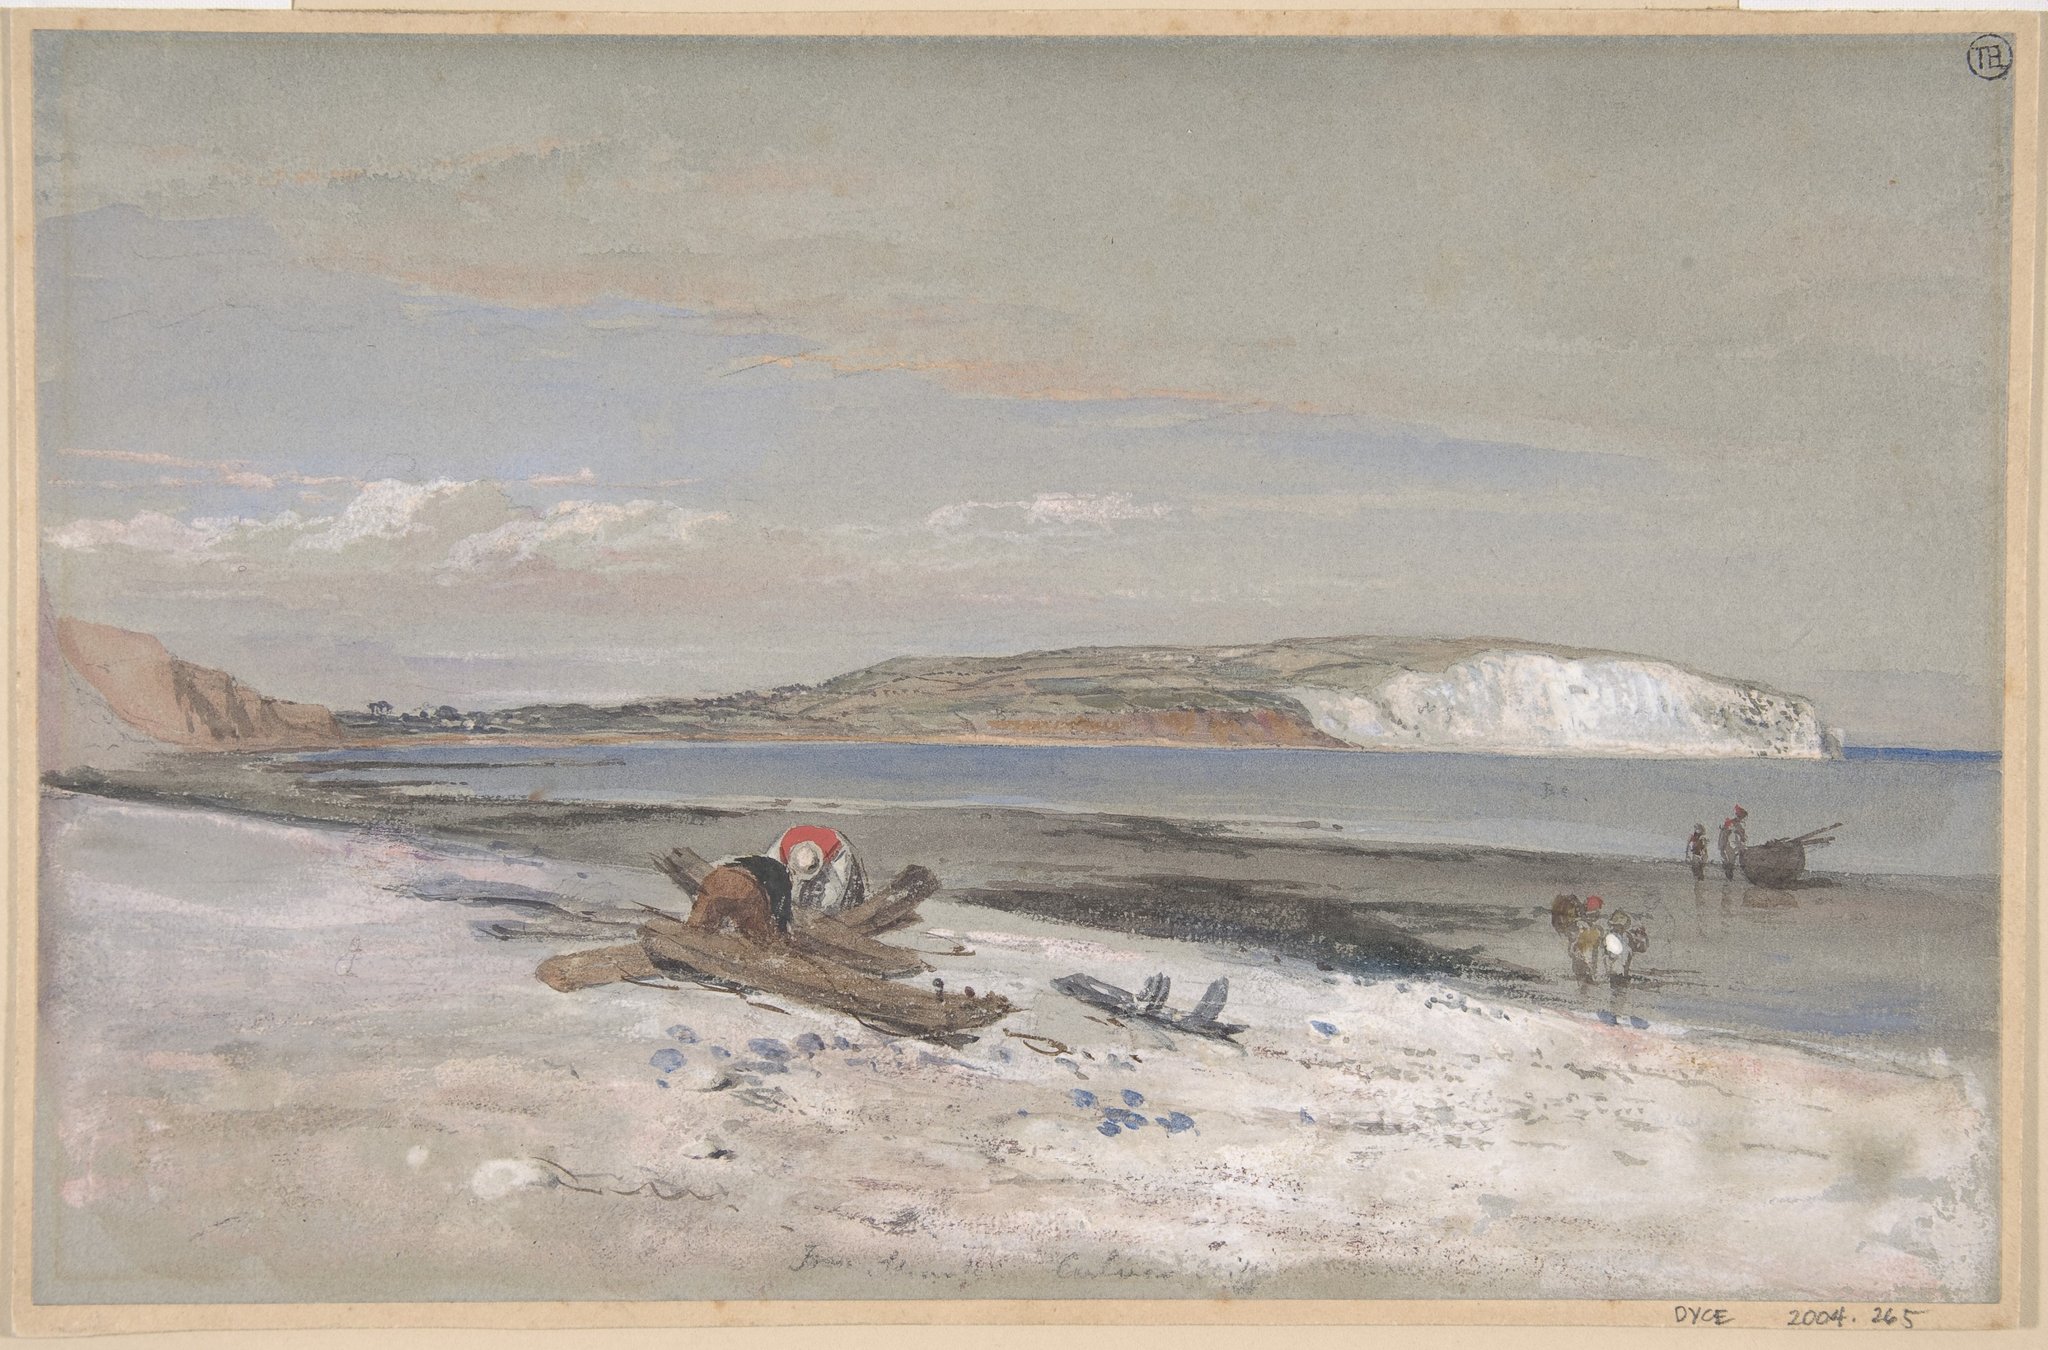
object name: drawing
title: Culver Cliff, Isle of Wight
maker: william dyce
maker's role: artist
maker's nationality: british, scottish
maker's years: 1806-1864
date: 1847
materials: chalk, gouache, graphite, watercolor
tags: beaches,landscapes